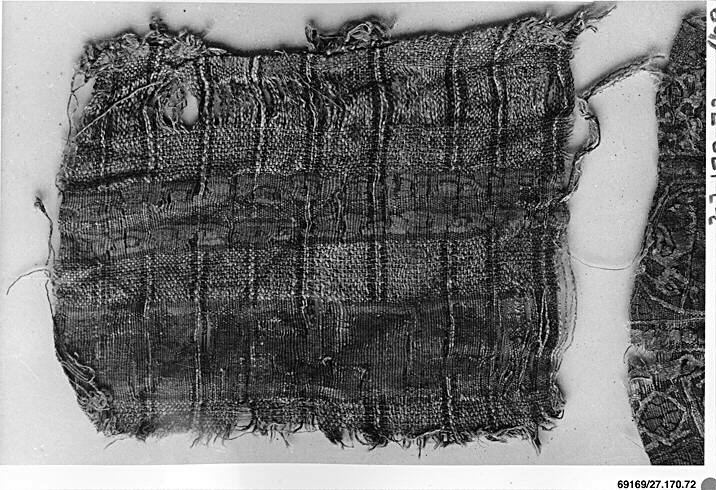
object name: textile fragment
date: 1101-1200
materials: linen, silk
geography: egypt